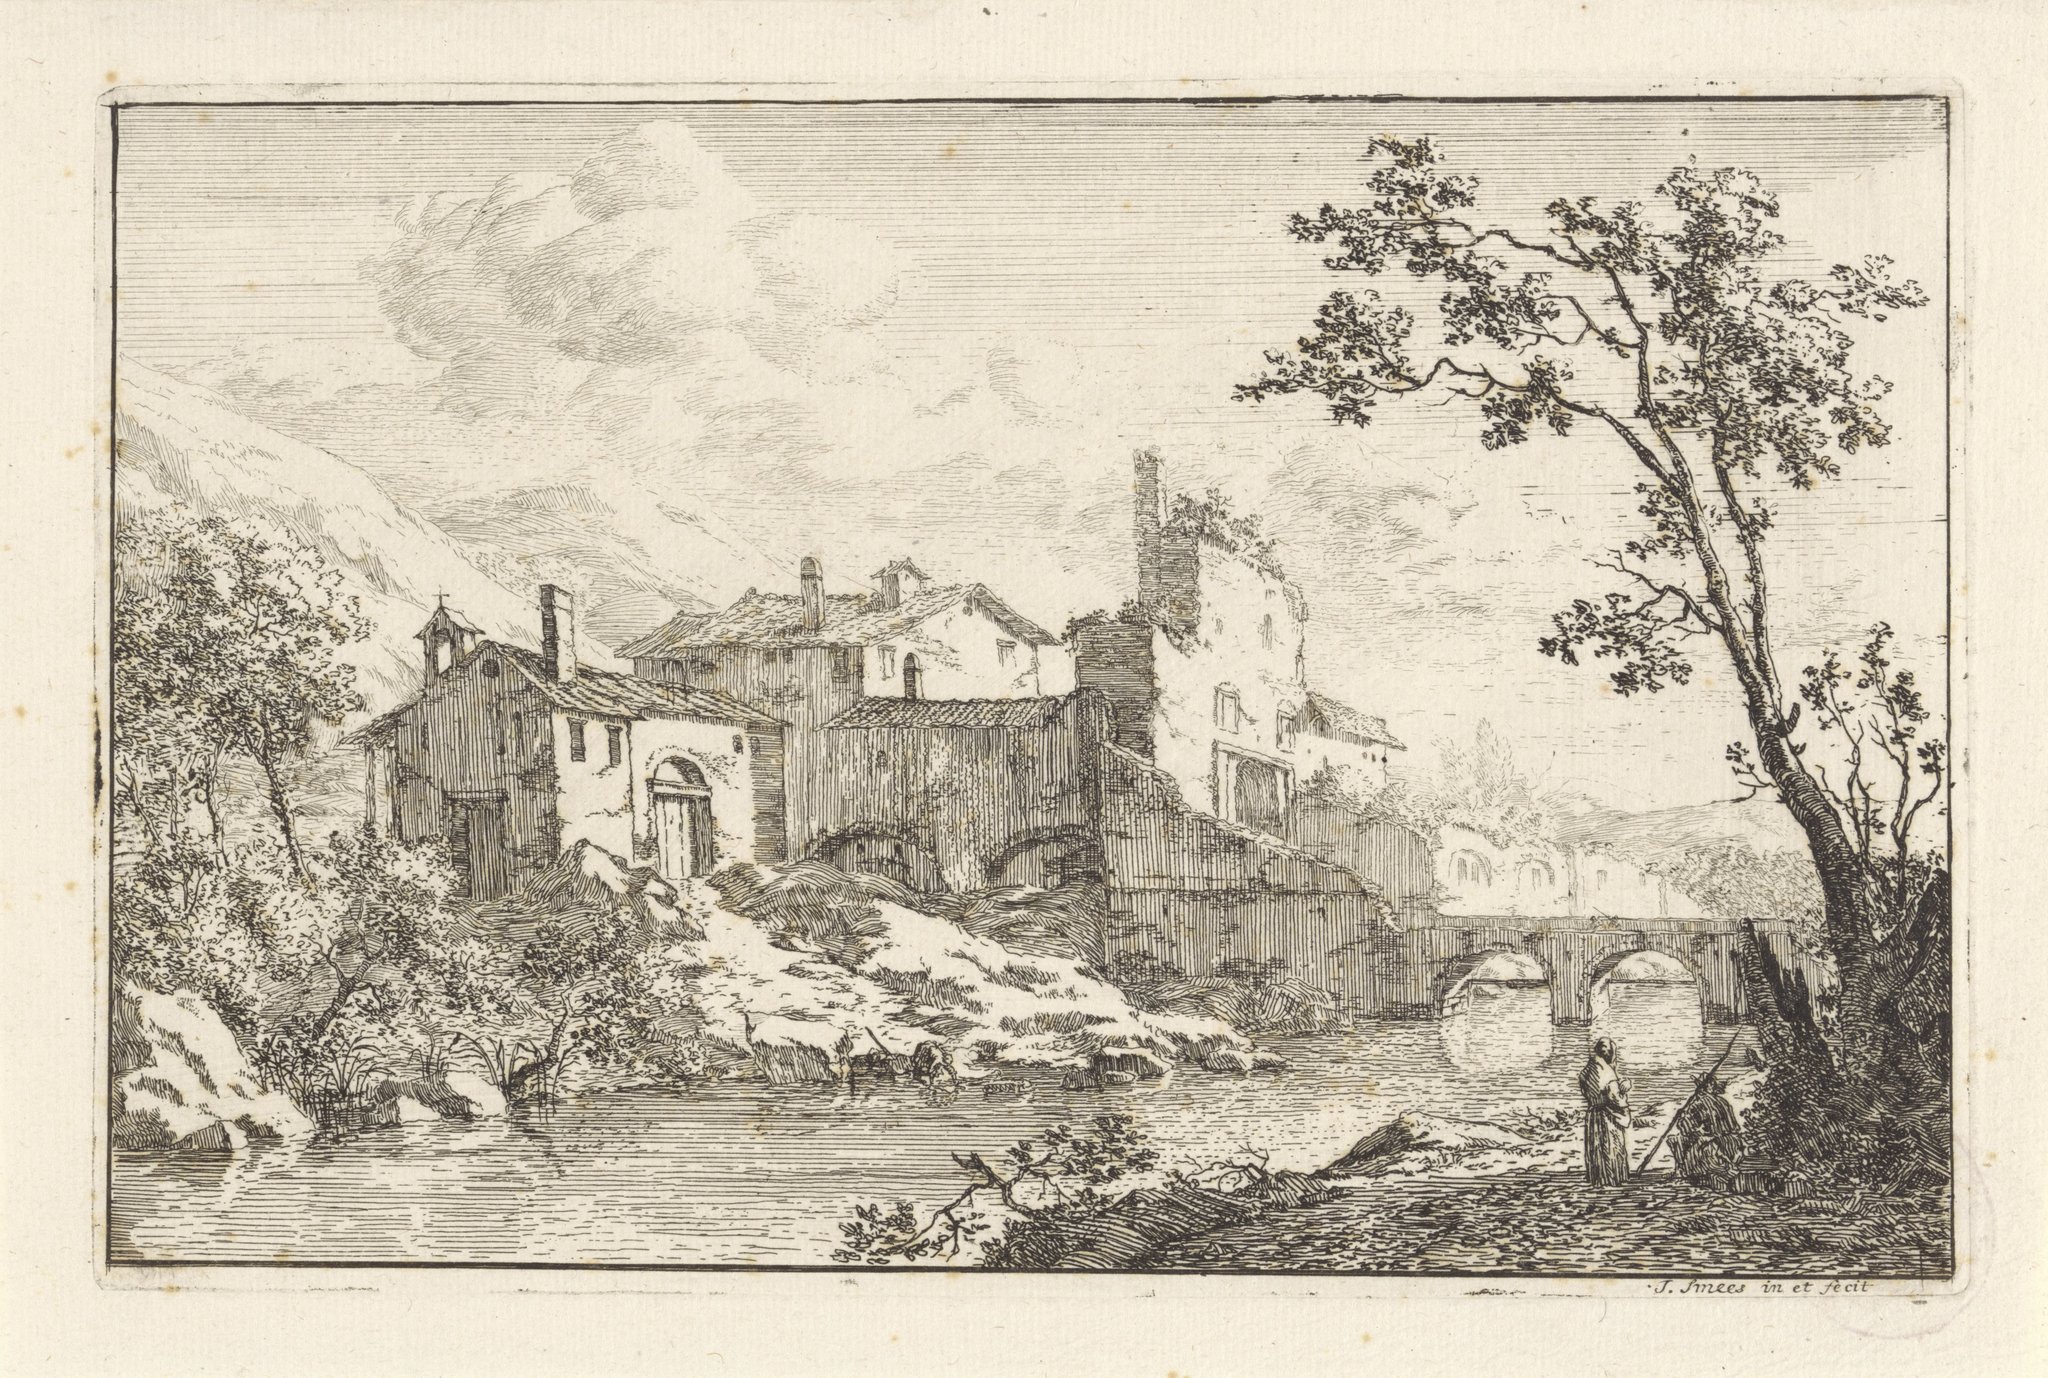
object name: print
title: Vervallen huis aan het water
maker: jan smees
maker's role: draughtsman, print maker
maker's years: 1670-1729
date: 1705-1729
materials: paper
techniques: etching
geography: amsterdam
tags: farm or solitary house in landscape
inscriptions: collector's mark: Lugt 240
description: Langs het water staat een vervallen huis met voorhof en kapelletje. Een brug leidt naar de toegangspoort. Op de voorgrond twee rustende mensen.